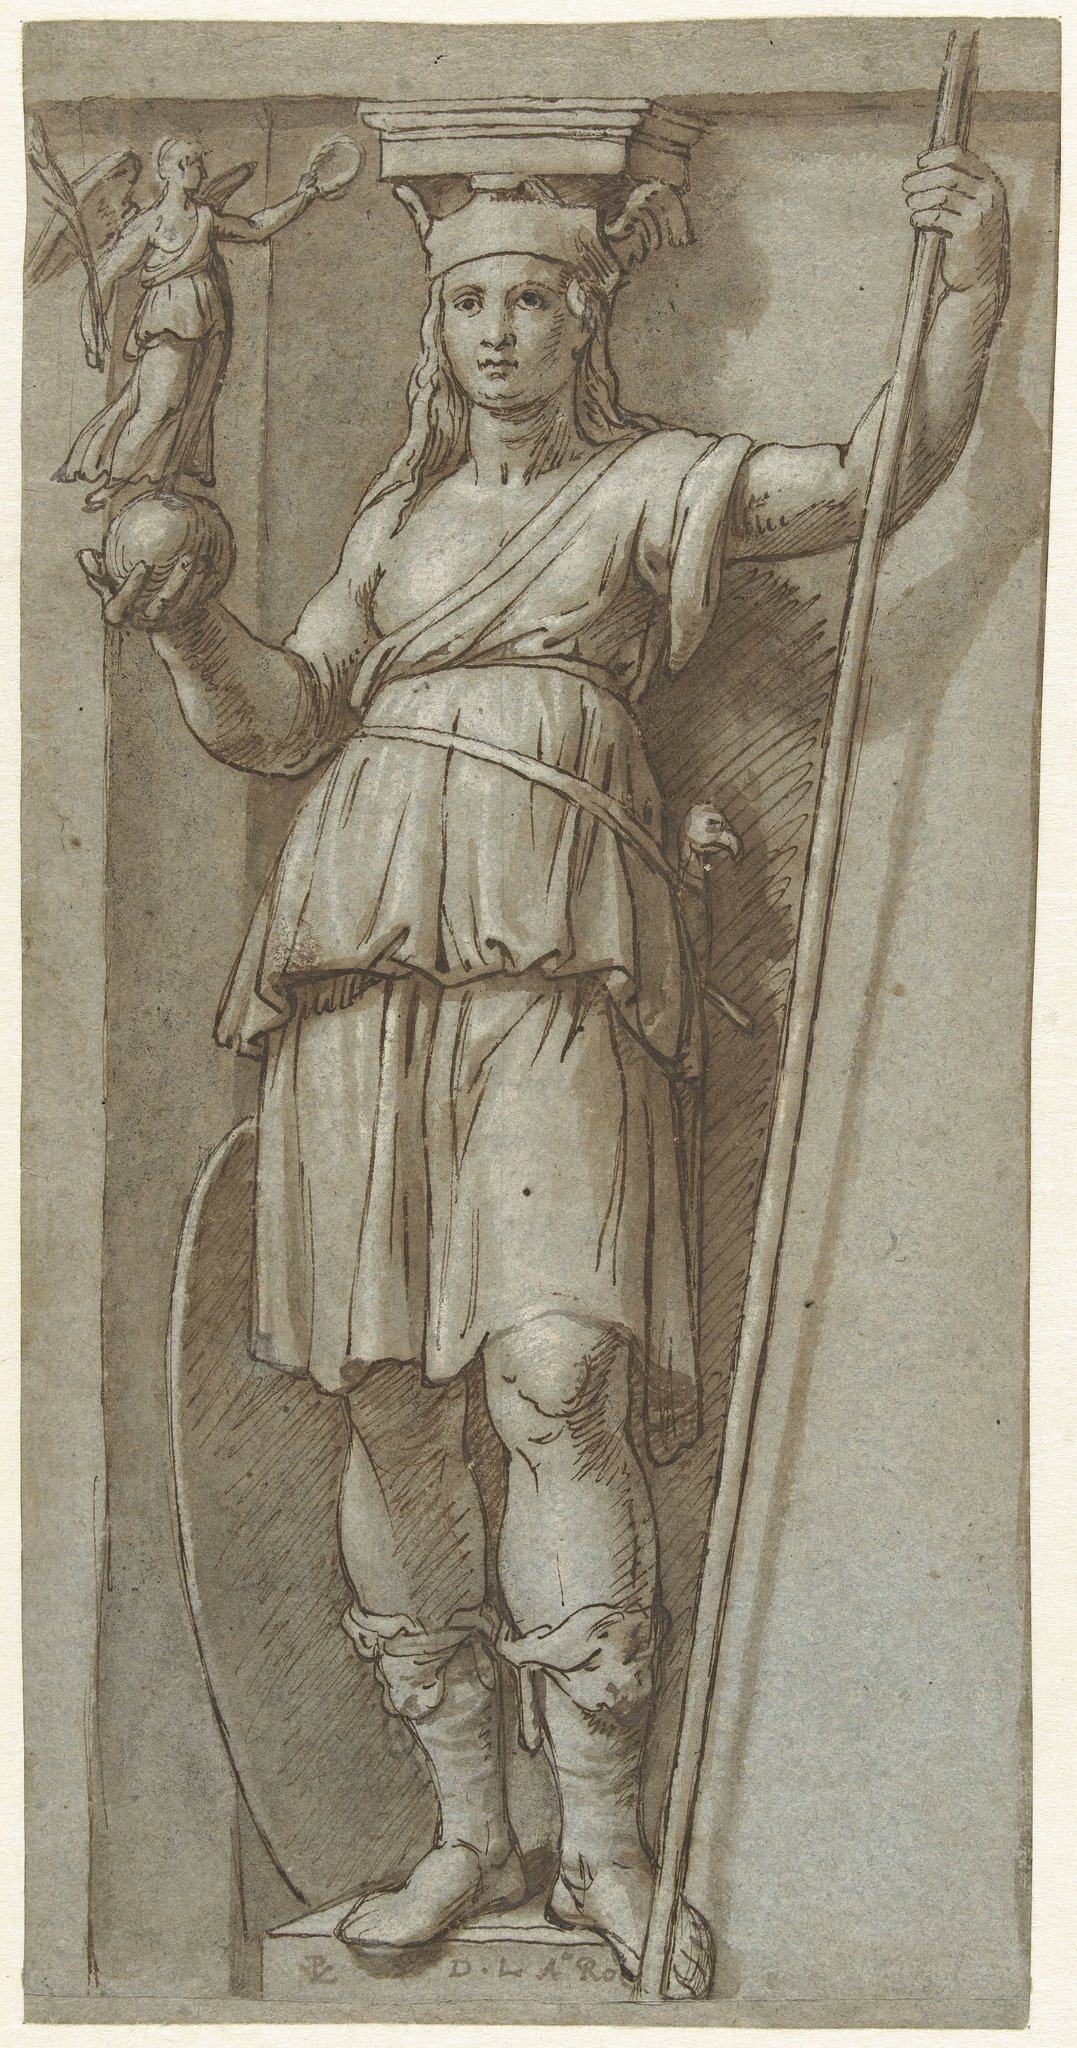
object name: drawing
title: Staande vrouw met een staf en een figuur op een bol in haar handen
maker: peter van lint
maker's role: draughtsman, painter, print maker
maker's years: 1609-1690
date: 1619-1690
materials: ink, paper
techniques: brush, pen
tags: rome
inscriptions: inscription: ‘onderaan naast monogram "D.L. A Ro.."’, monogram: ‘onderaan monogram "PVL" (ineen)’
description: Staande vrouwenfiguur onder een fresco in de Stanza de Heliodoro naar Raffaello. De vrouwenfiguur houdt in haar linkerhand een staf vast en in de rechterhand een bol met daarop een allegorische figuur met vleugels, een lauwerkrans en een palmtak vasthoudend; links van de vrouw en half achter haar rechterbeen staat een schild, ze draagt laarsachtig schoeisel en op haar hoofd een helm met vleugeltjes, op haar linkerheup rust een schede met een dolk of zwaard.